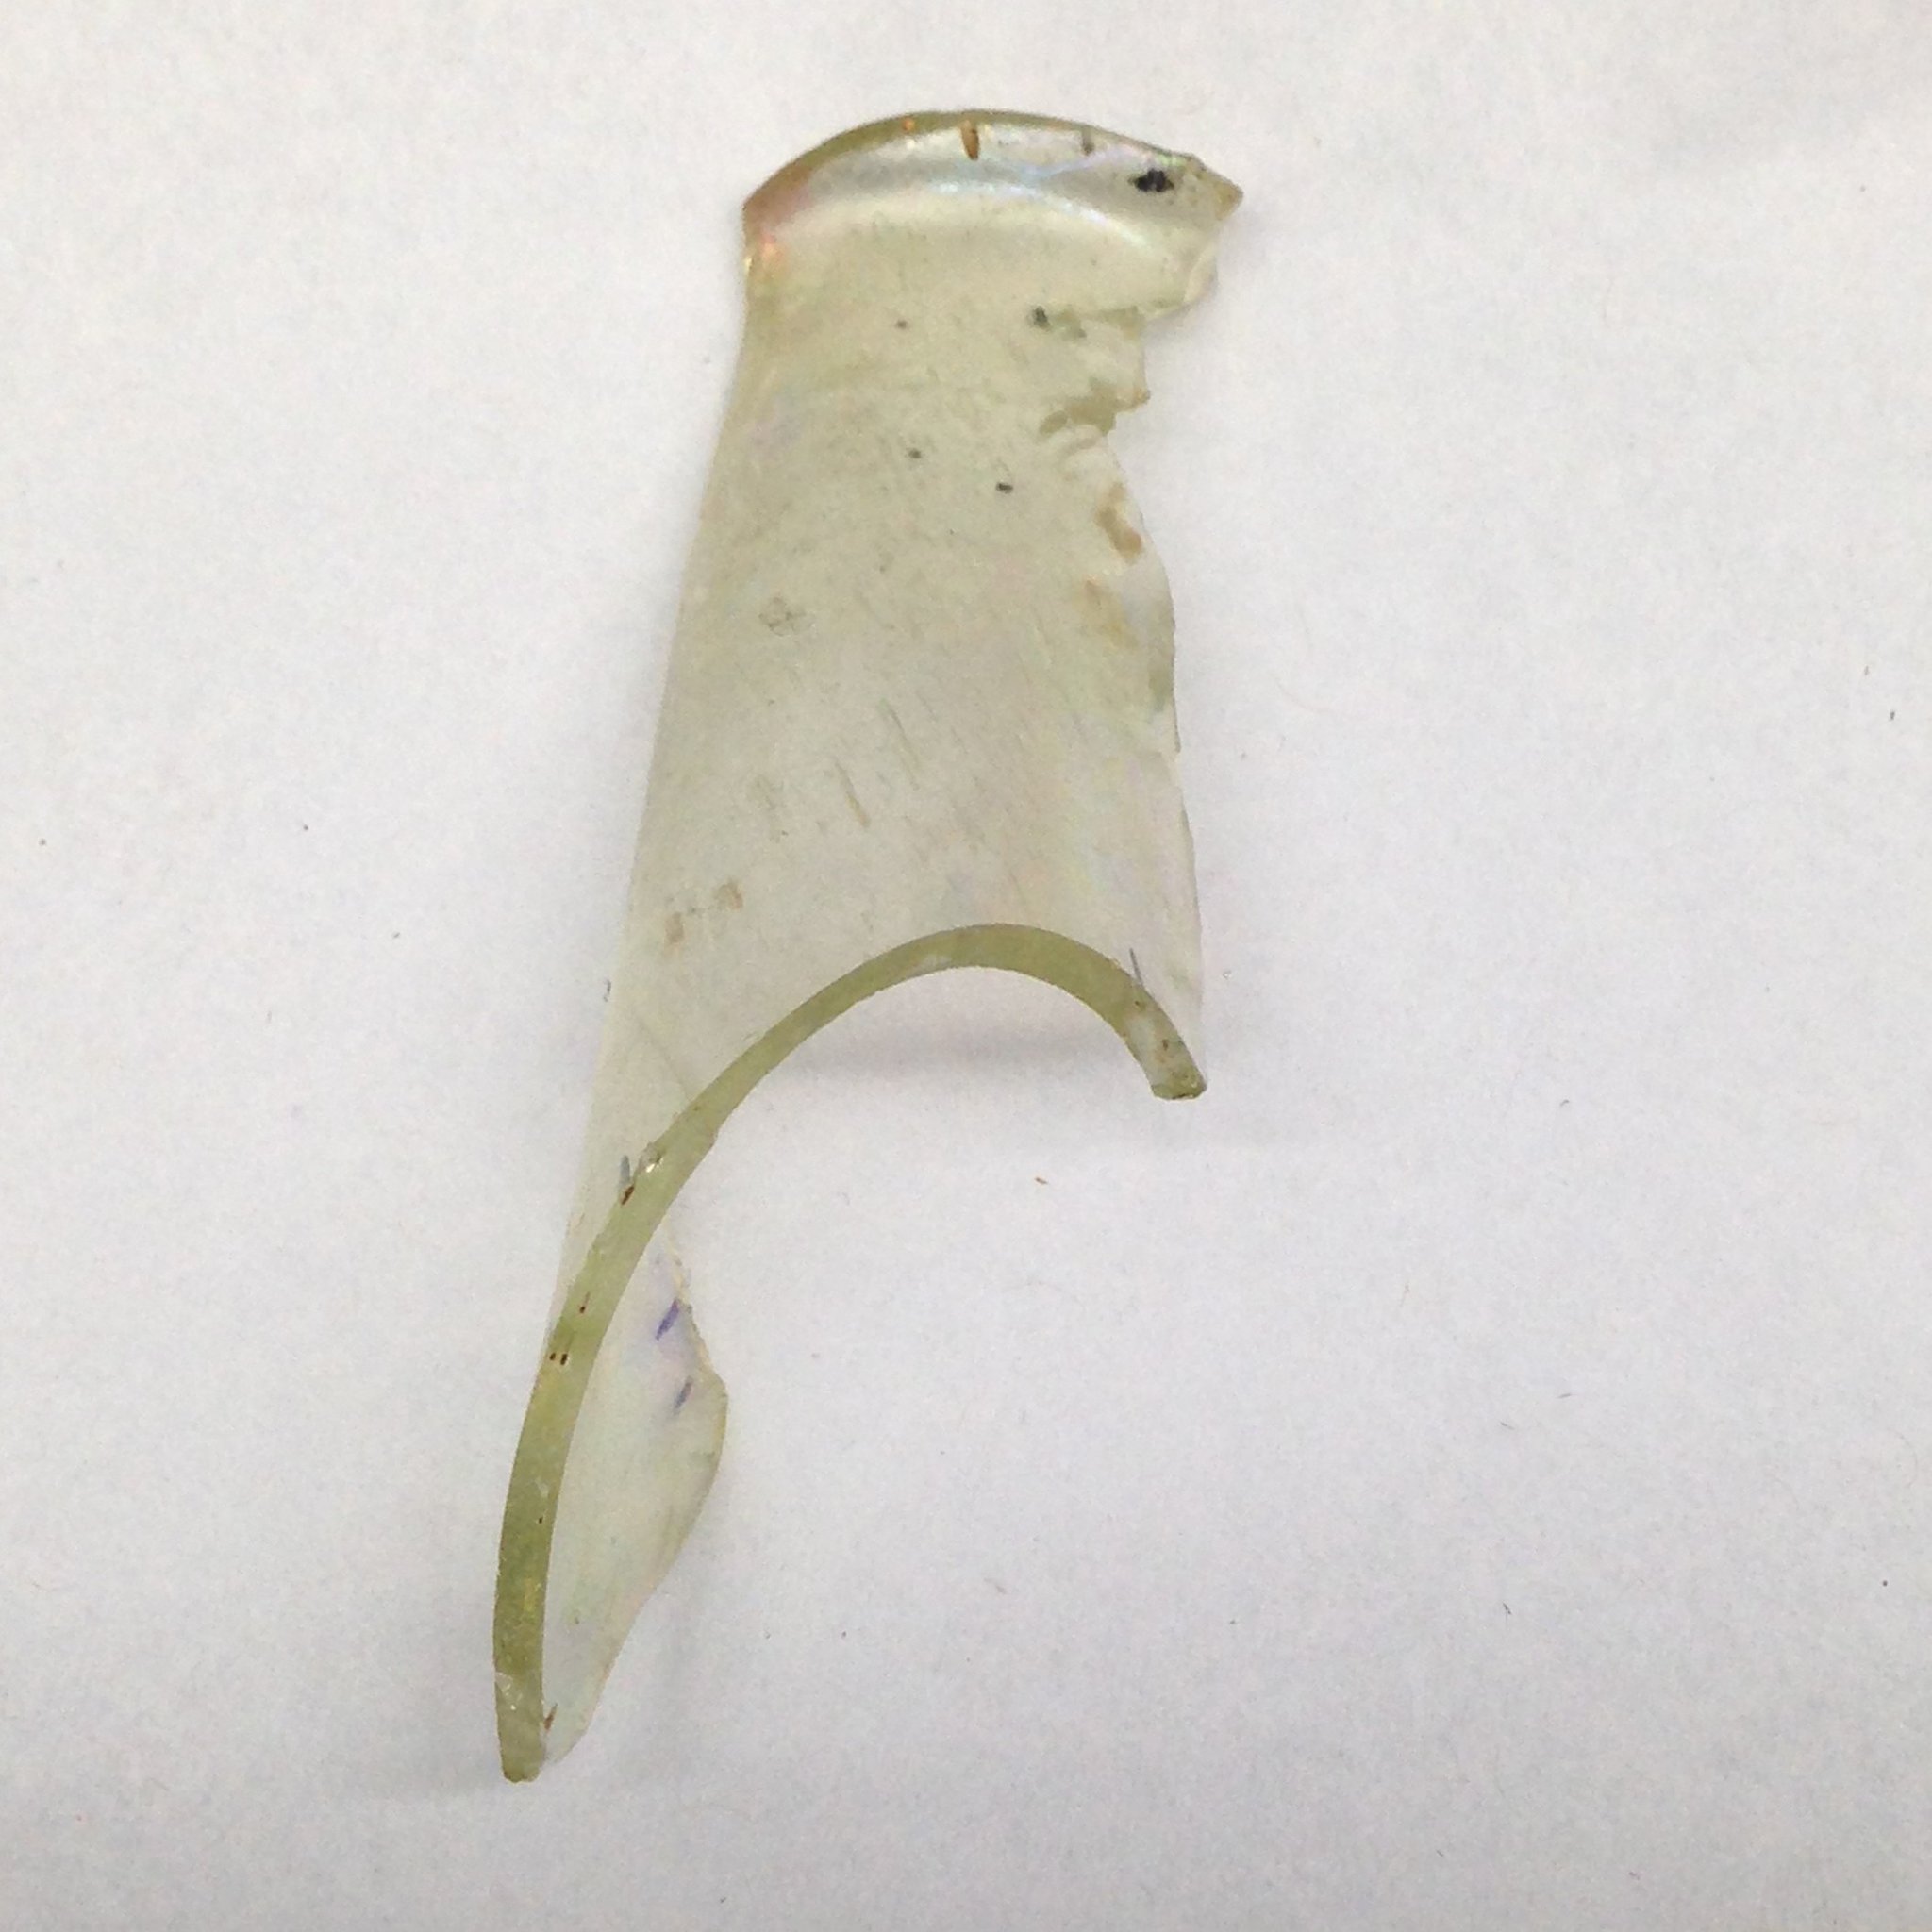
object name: fragment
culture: european or middle eastern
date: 1150-1250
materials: ceramic, glass